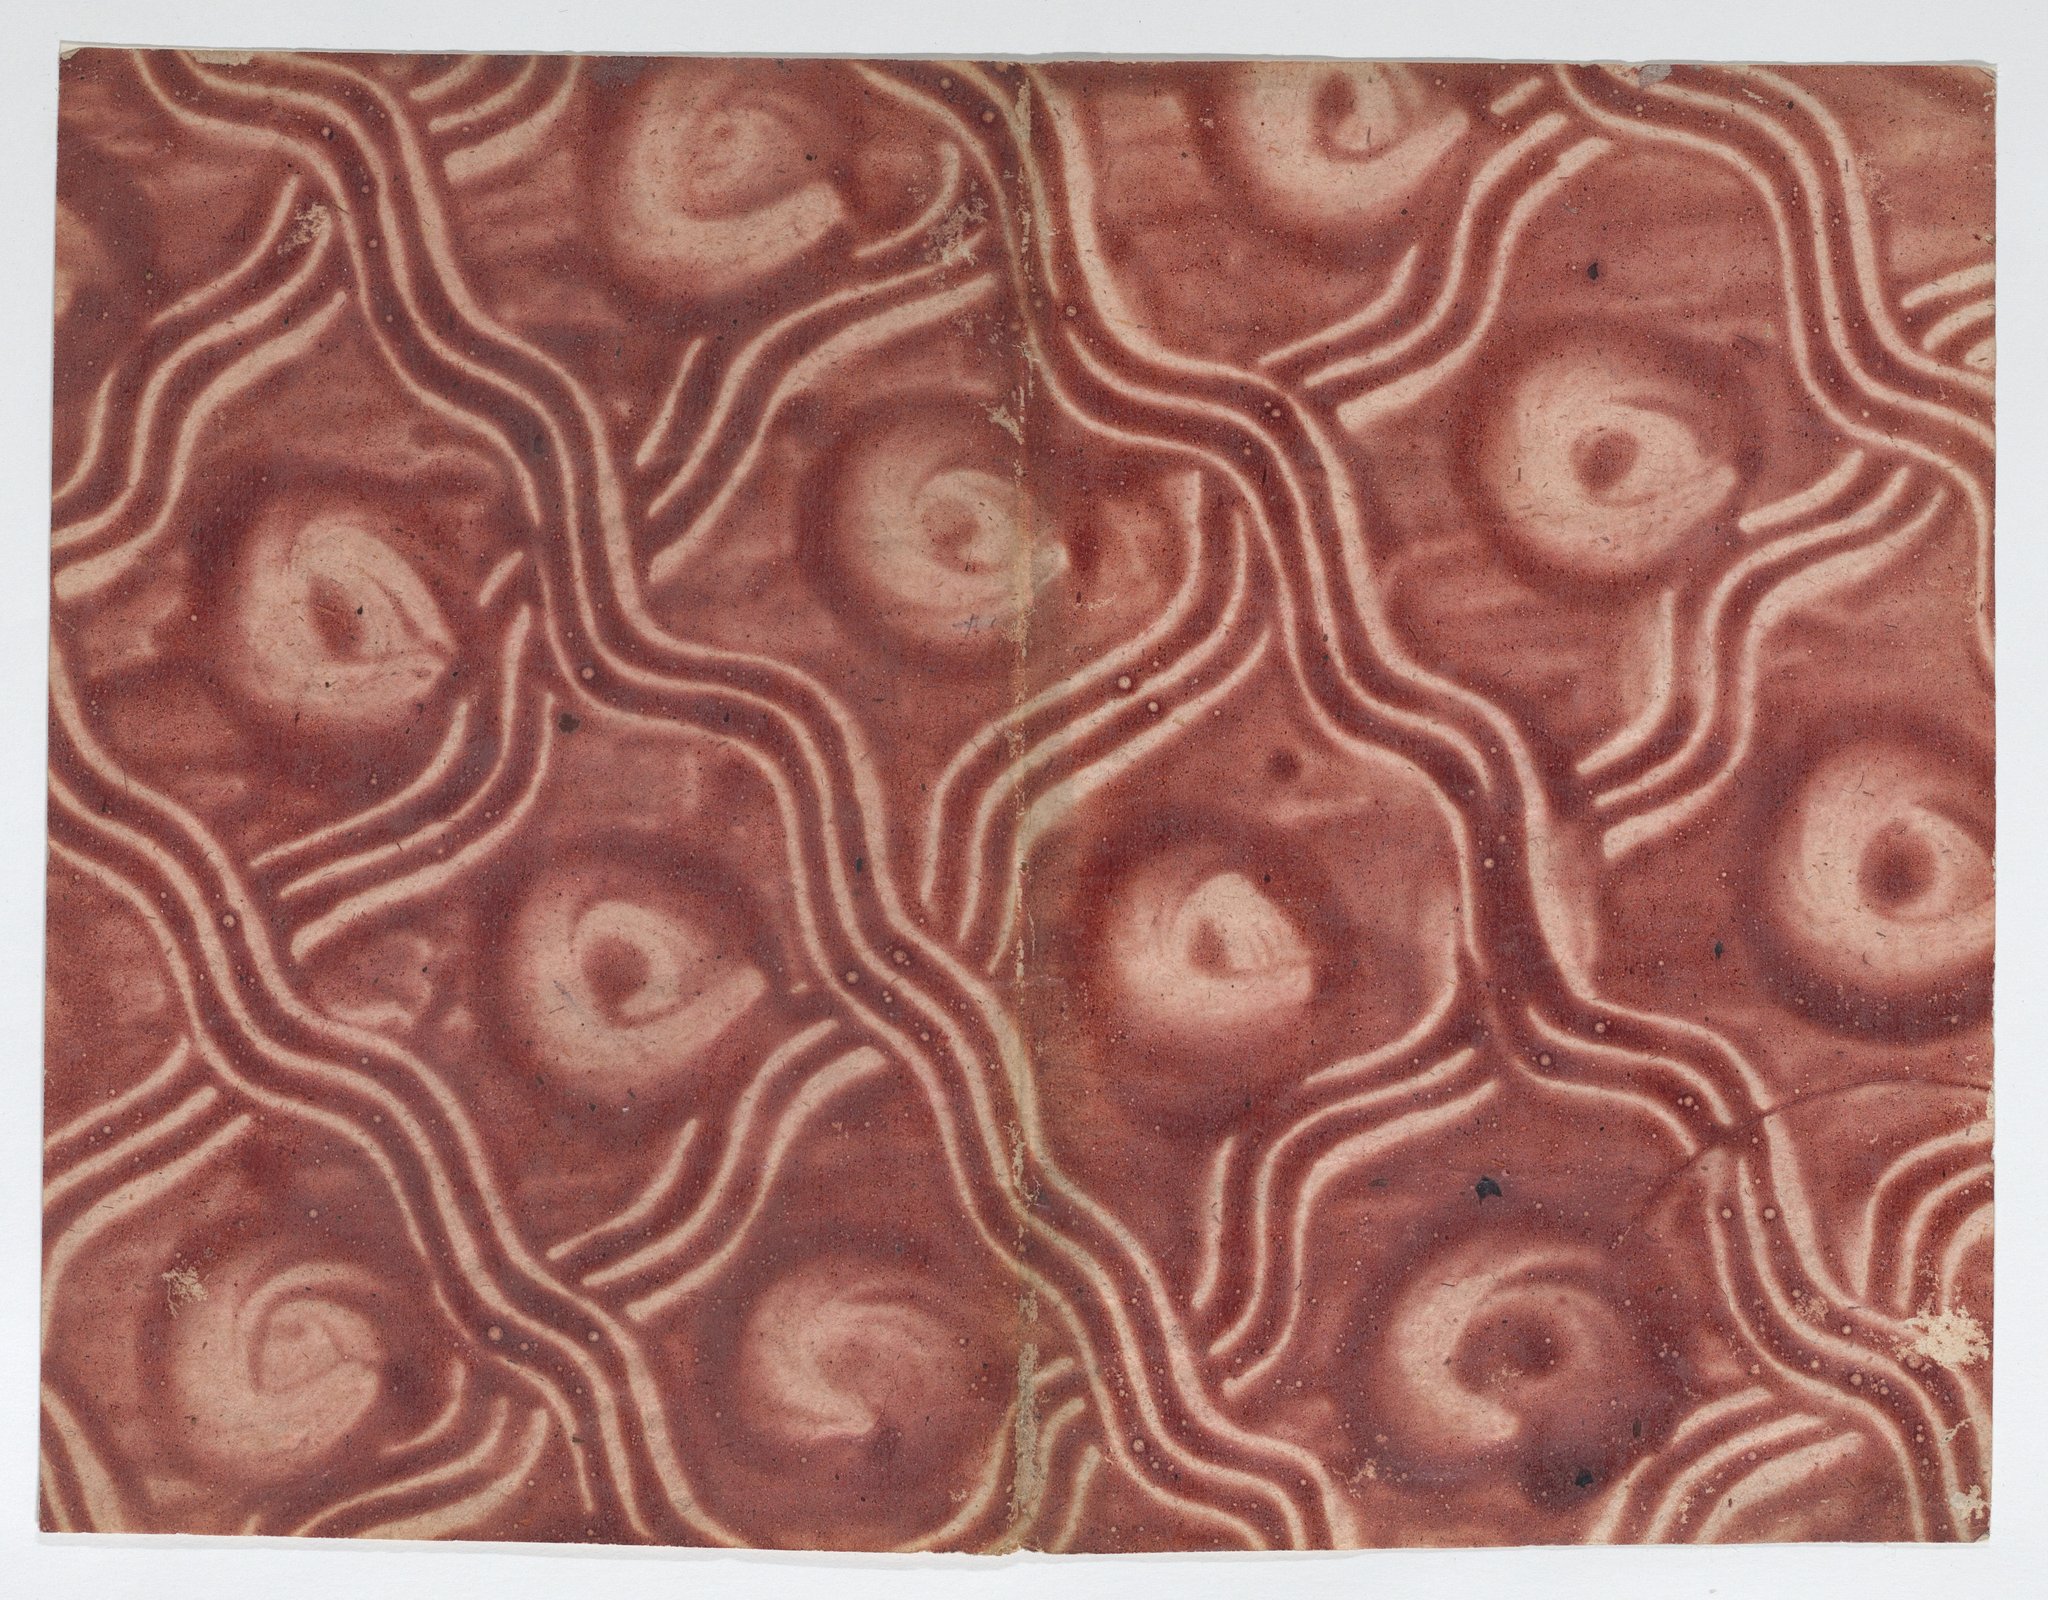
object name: print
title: Book cover with overall pattern of red curved lines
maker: Anonymous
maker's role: artist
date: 1701-1800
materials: paper, paste